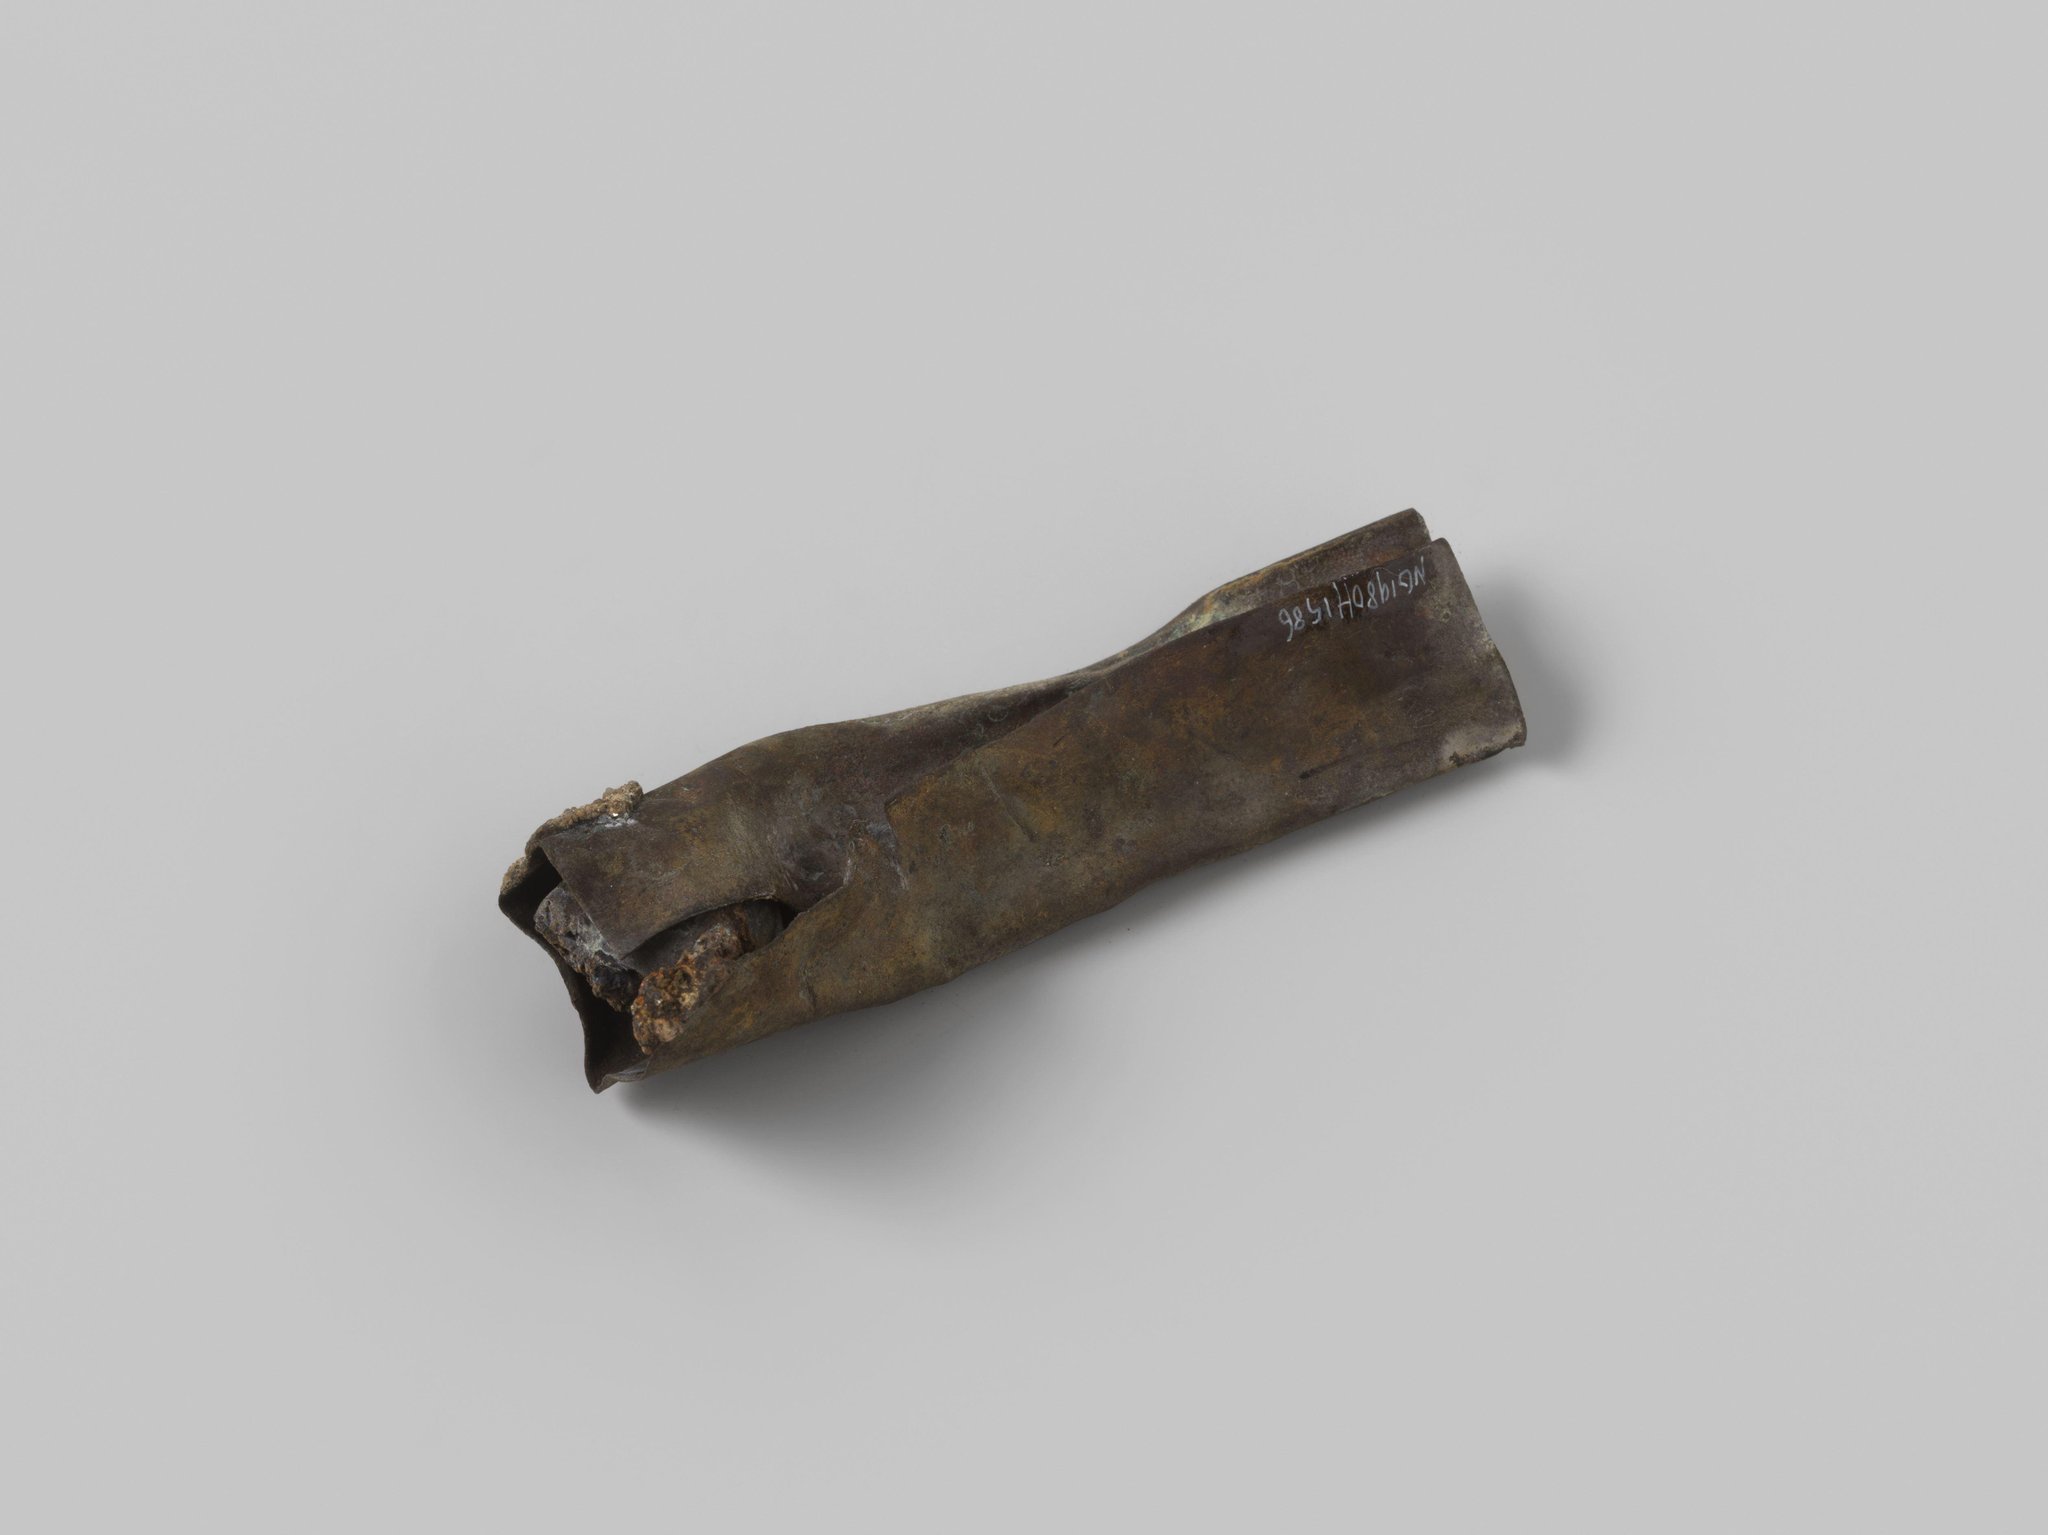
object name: cartridge shell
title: Patroonhuls met kogel uit het wrak van de Oost-Indiëvaarder Hollandia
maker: Anonymous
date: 1700-1743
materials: copper, lead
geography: netherlands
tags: verenigde oostindische compagnie, hollandia (schip), annet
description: Cartridge case, tube; squashed, bent, id. NG 1979-205H549, with lead shot.